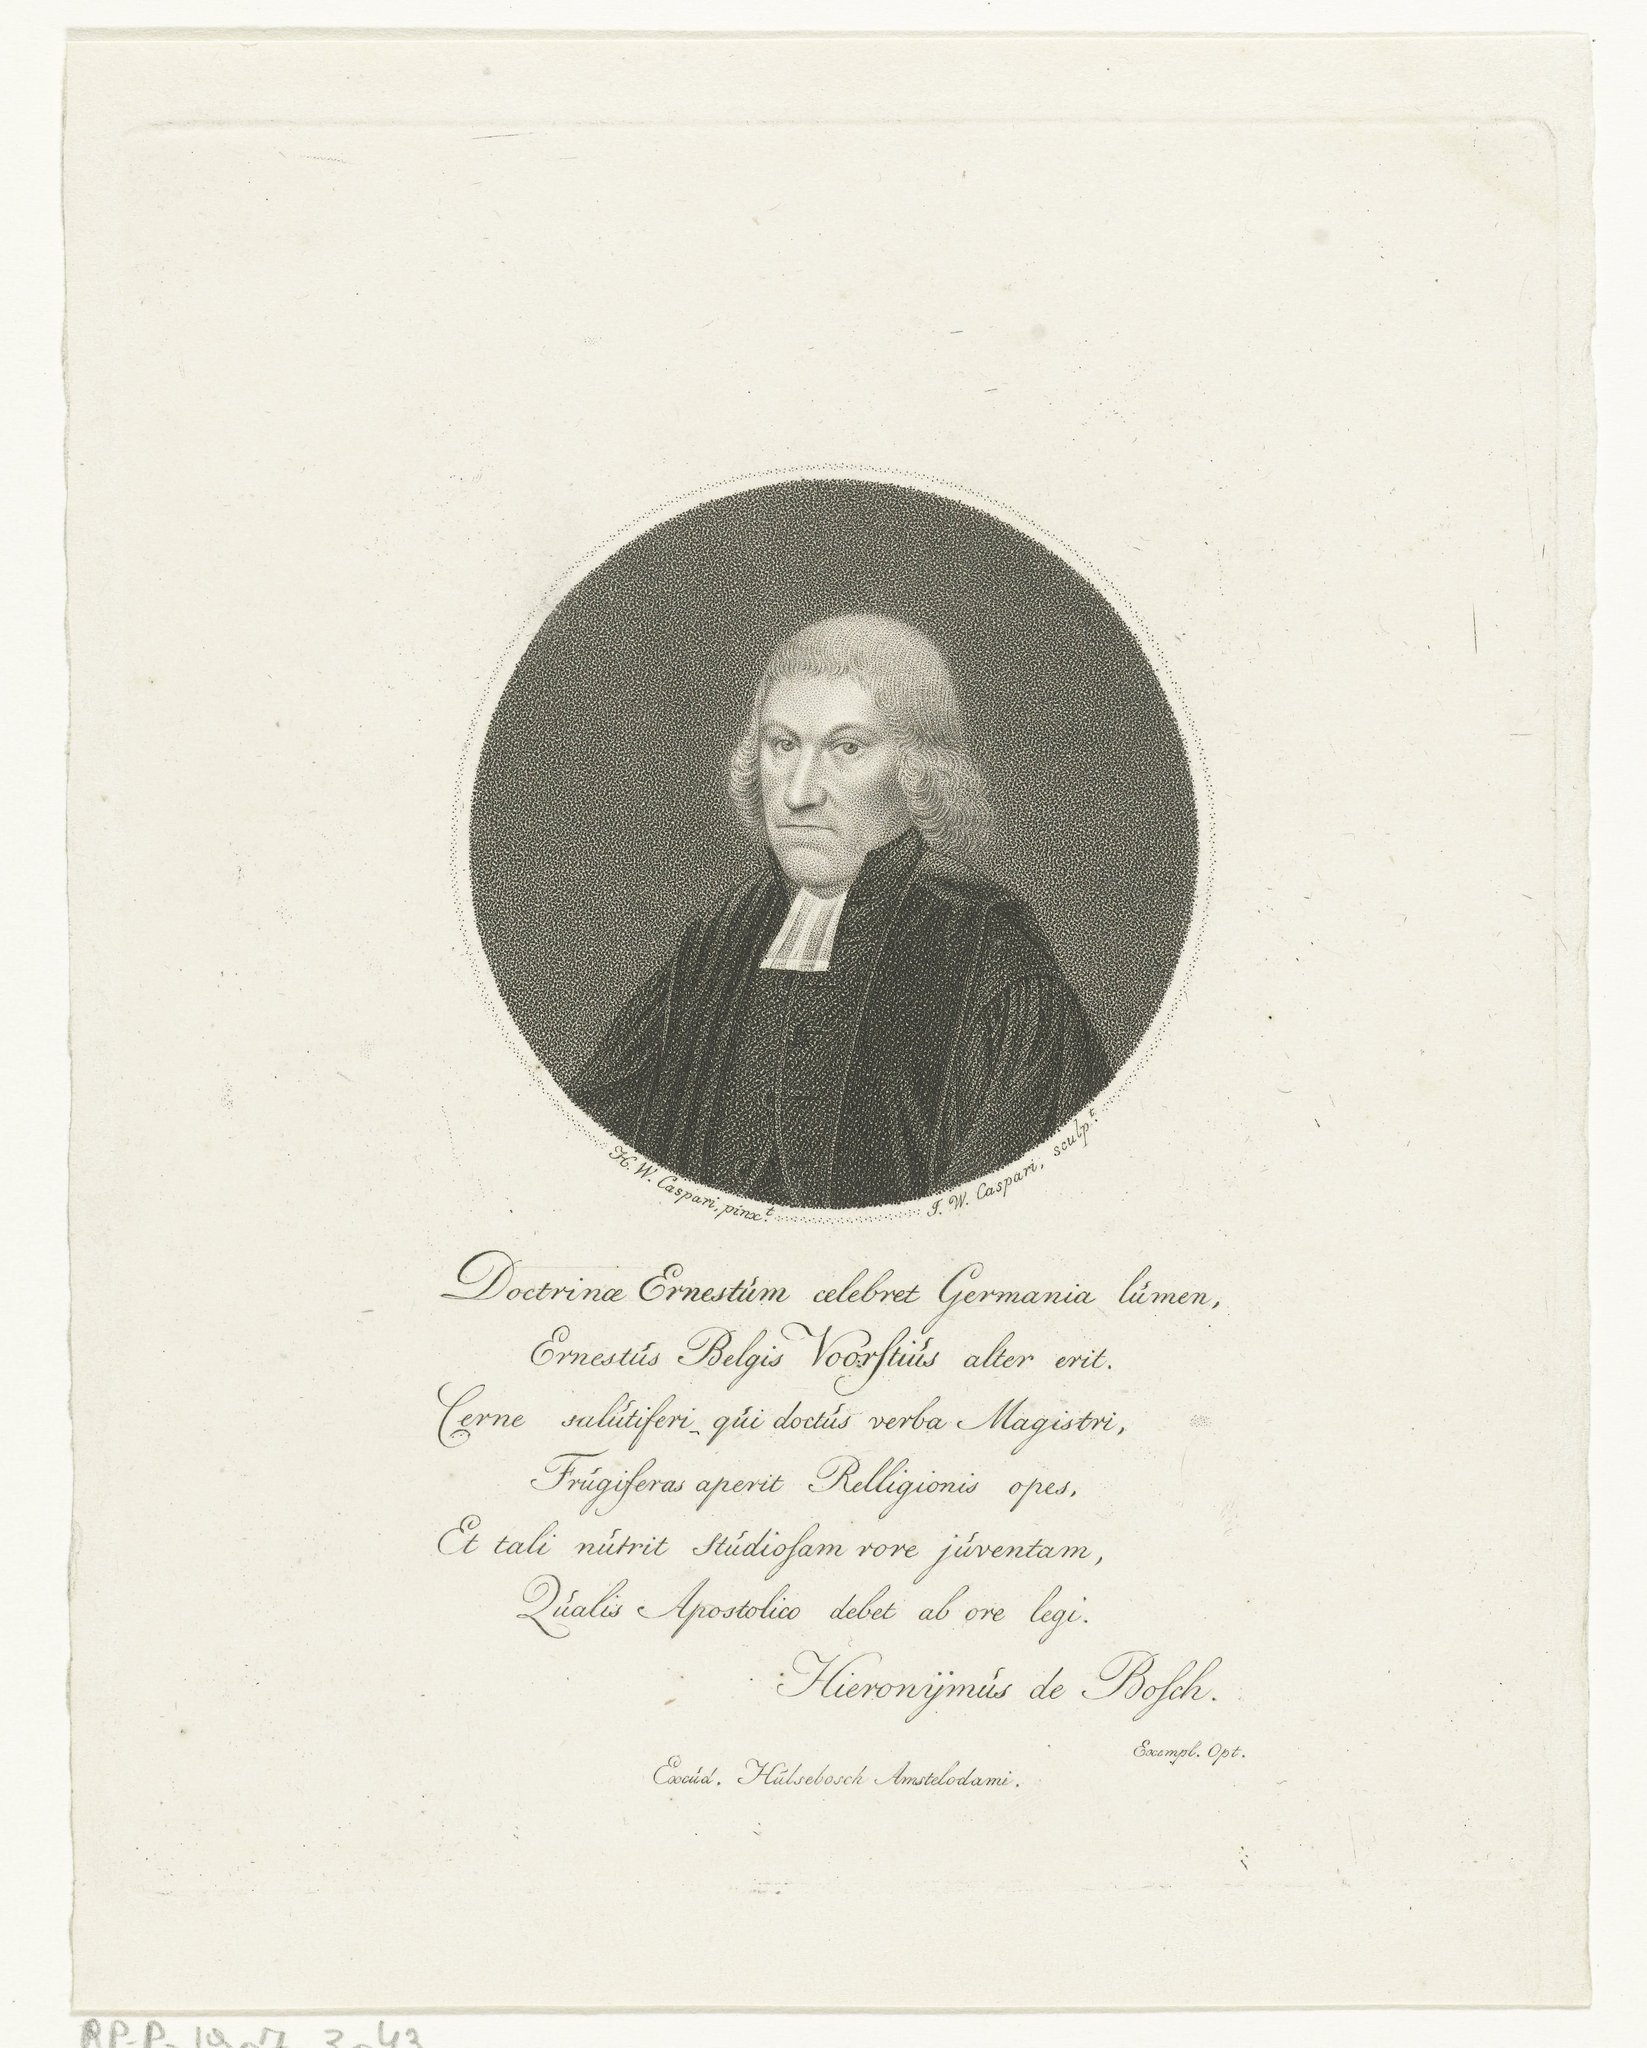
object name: print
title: Portret van Johannes van Voorst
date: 1789-1822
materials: paper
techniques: etching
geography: amsterdam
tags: leiden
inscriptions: collector's mark: Lugt 2228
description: Portret in ronde lijst van Johannes van Voorst, predikant te Halle bij Zutphen, Wageningen en Zierikzee. Buste naar links. Voorst heeft een zwarte toga aan met een witte bef. De prent heeft een Latijns onderschrift met naam van de geportretteerde en een gedicht.